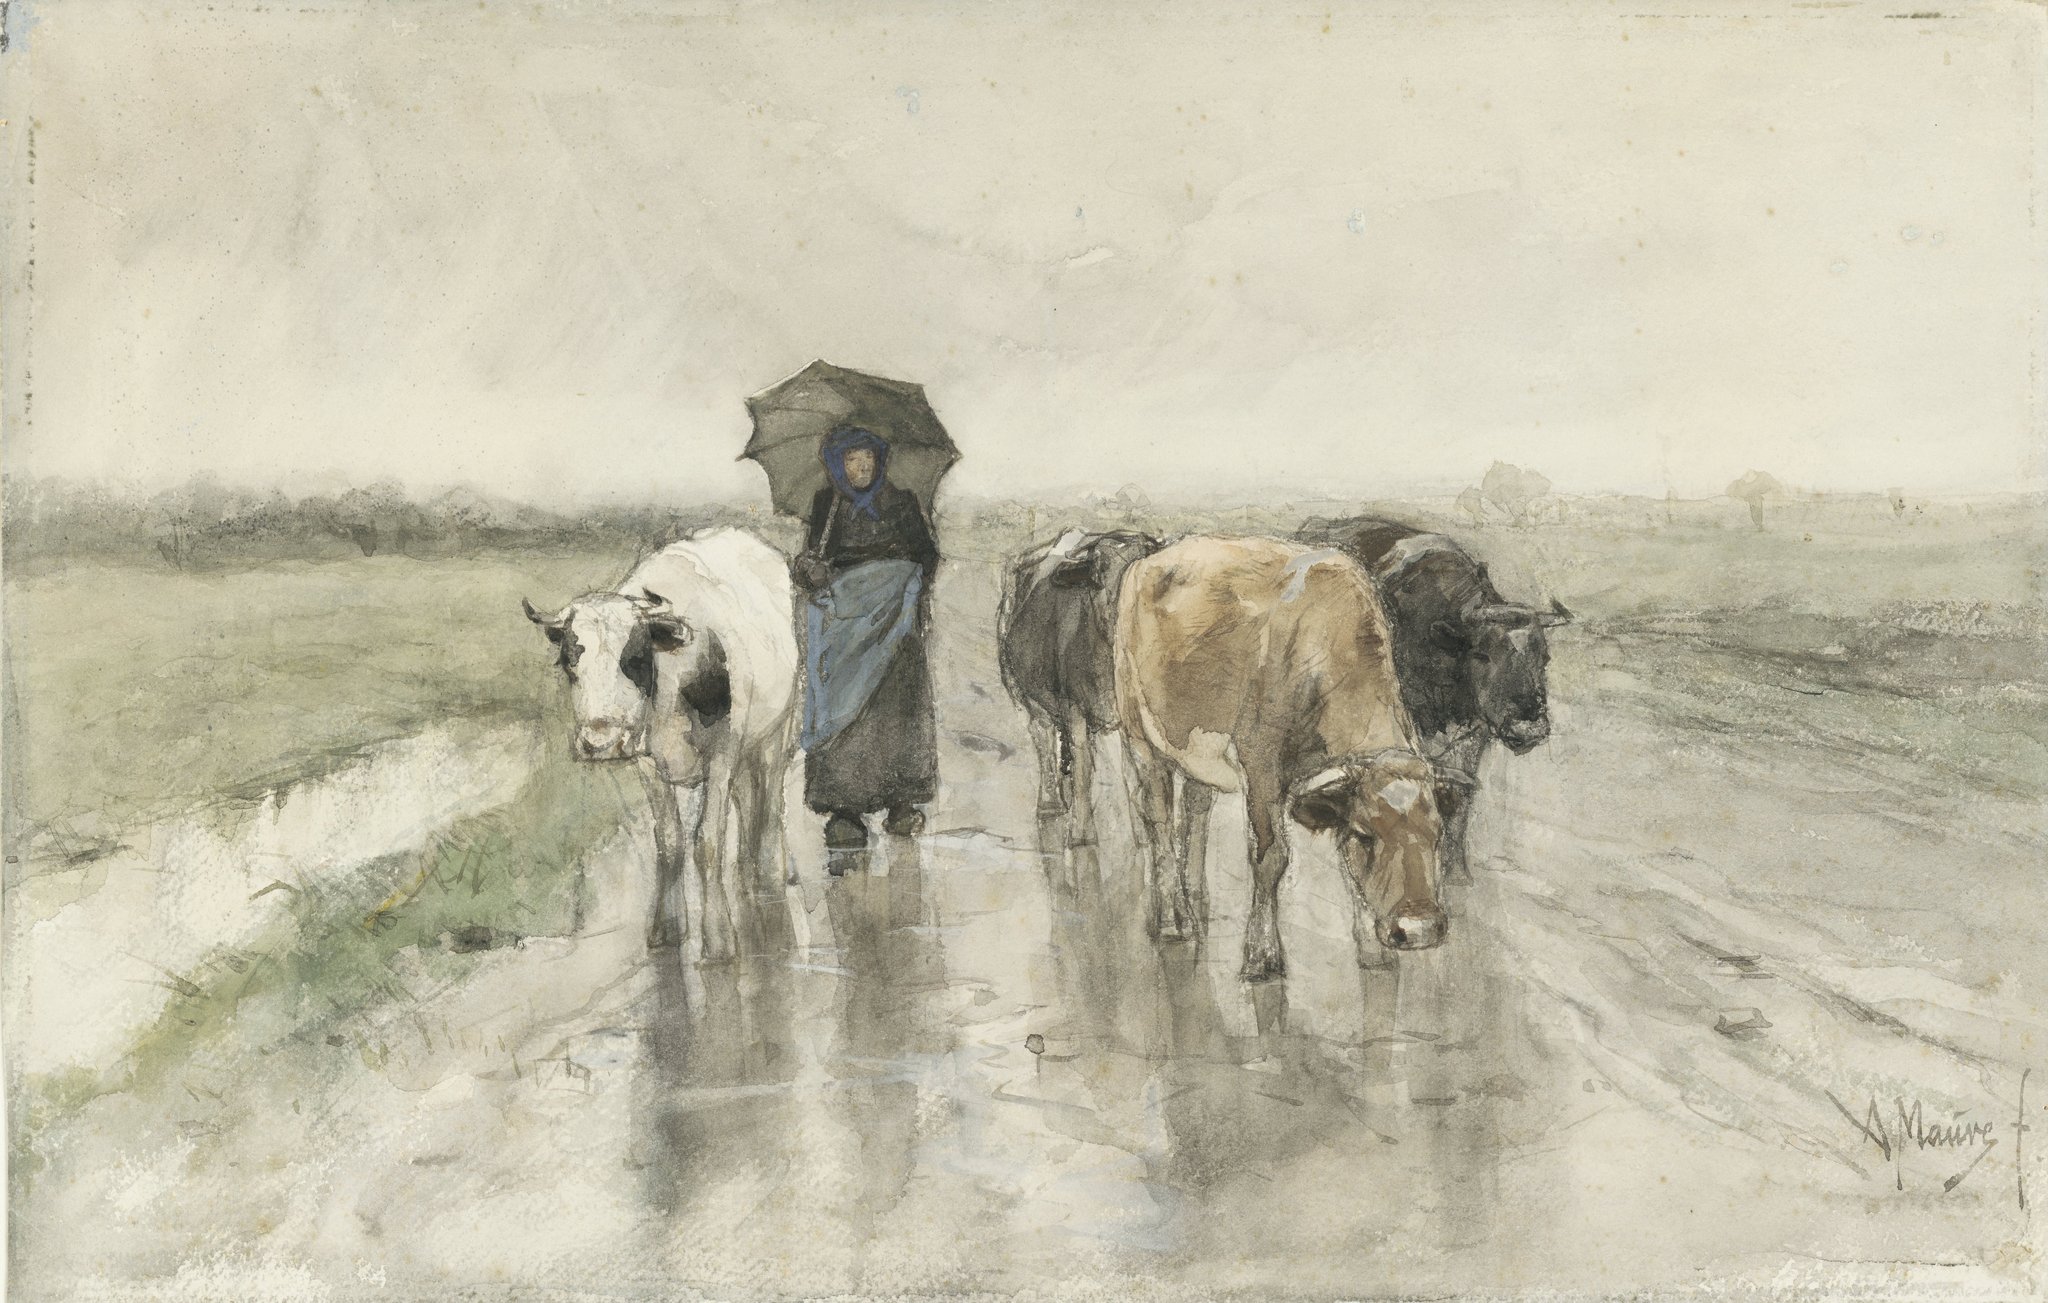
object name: drawing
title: A Herdess with Cows on a Country Road in the Rain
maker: anton mauve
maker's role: draughtsman, painter, print maker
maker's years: 1838-1888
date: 1848-1888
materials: chalk, paper, watercolor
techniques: brush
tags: cow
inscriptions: signature: ‘A Mauve f.’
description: A herdess is walking under her umbrella as she drives her four cows forward. ‘The soaking wet atmosphere is captured so well that one’s feet start to feel wet if one looks at the work too long,’ one critic wrote. In contrast to Mauve’s pictures of horse-riders, where the horses always move towards the horizon, the cows in his cattle paintings generally head straight at the viewer.